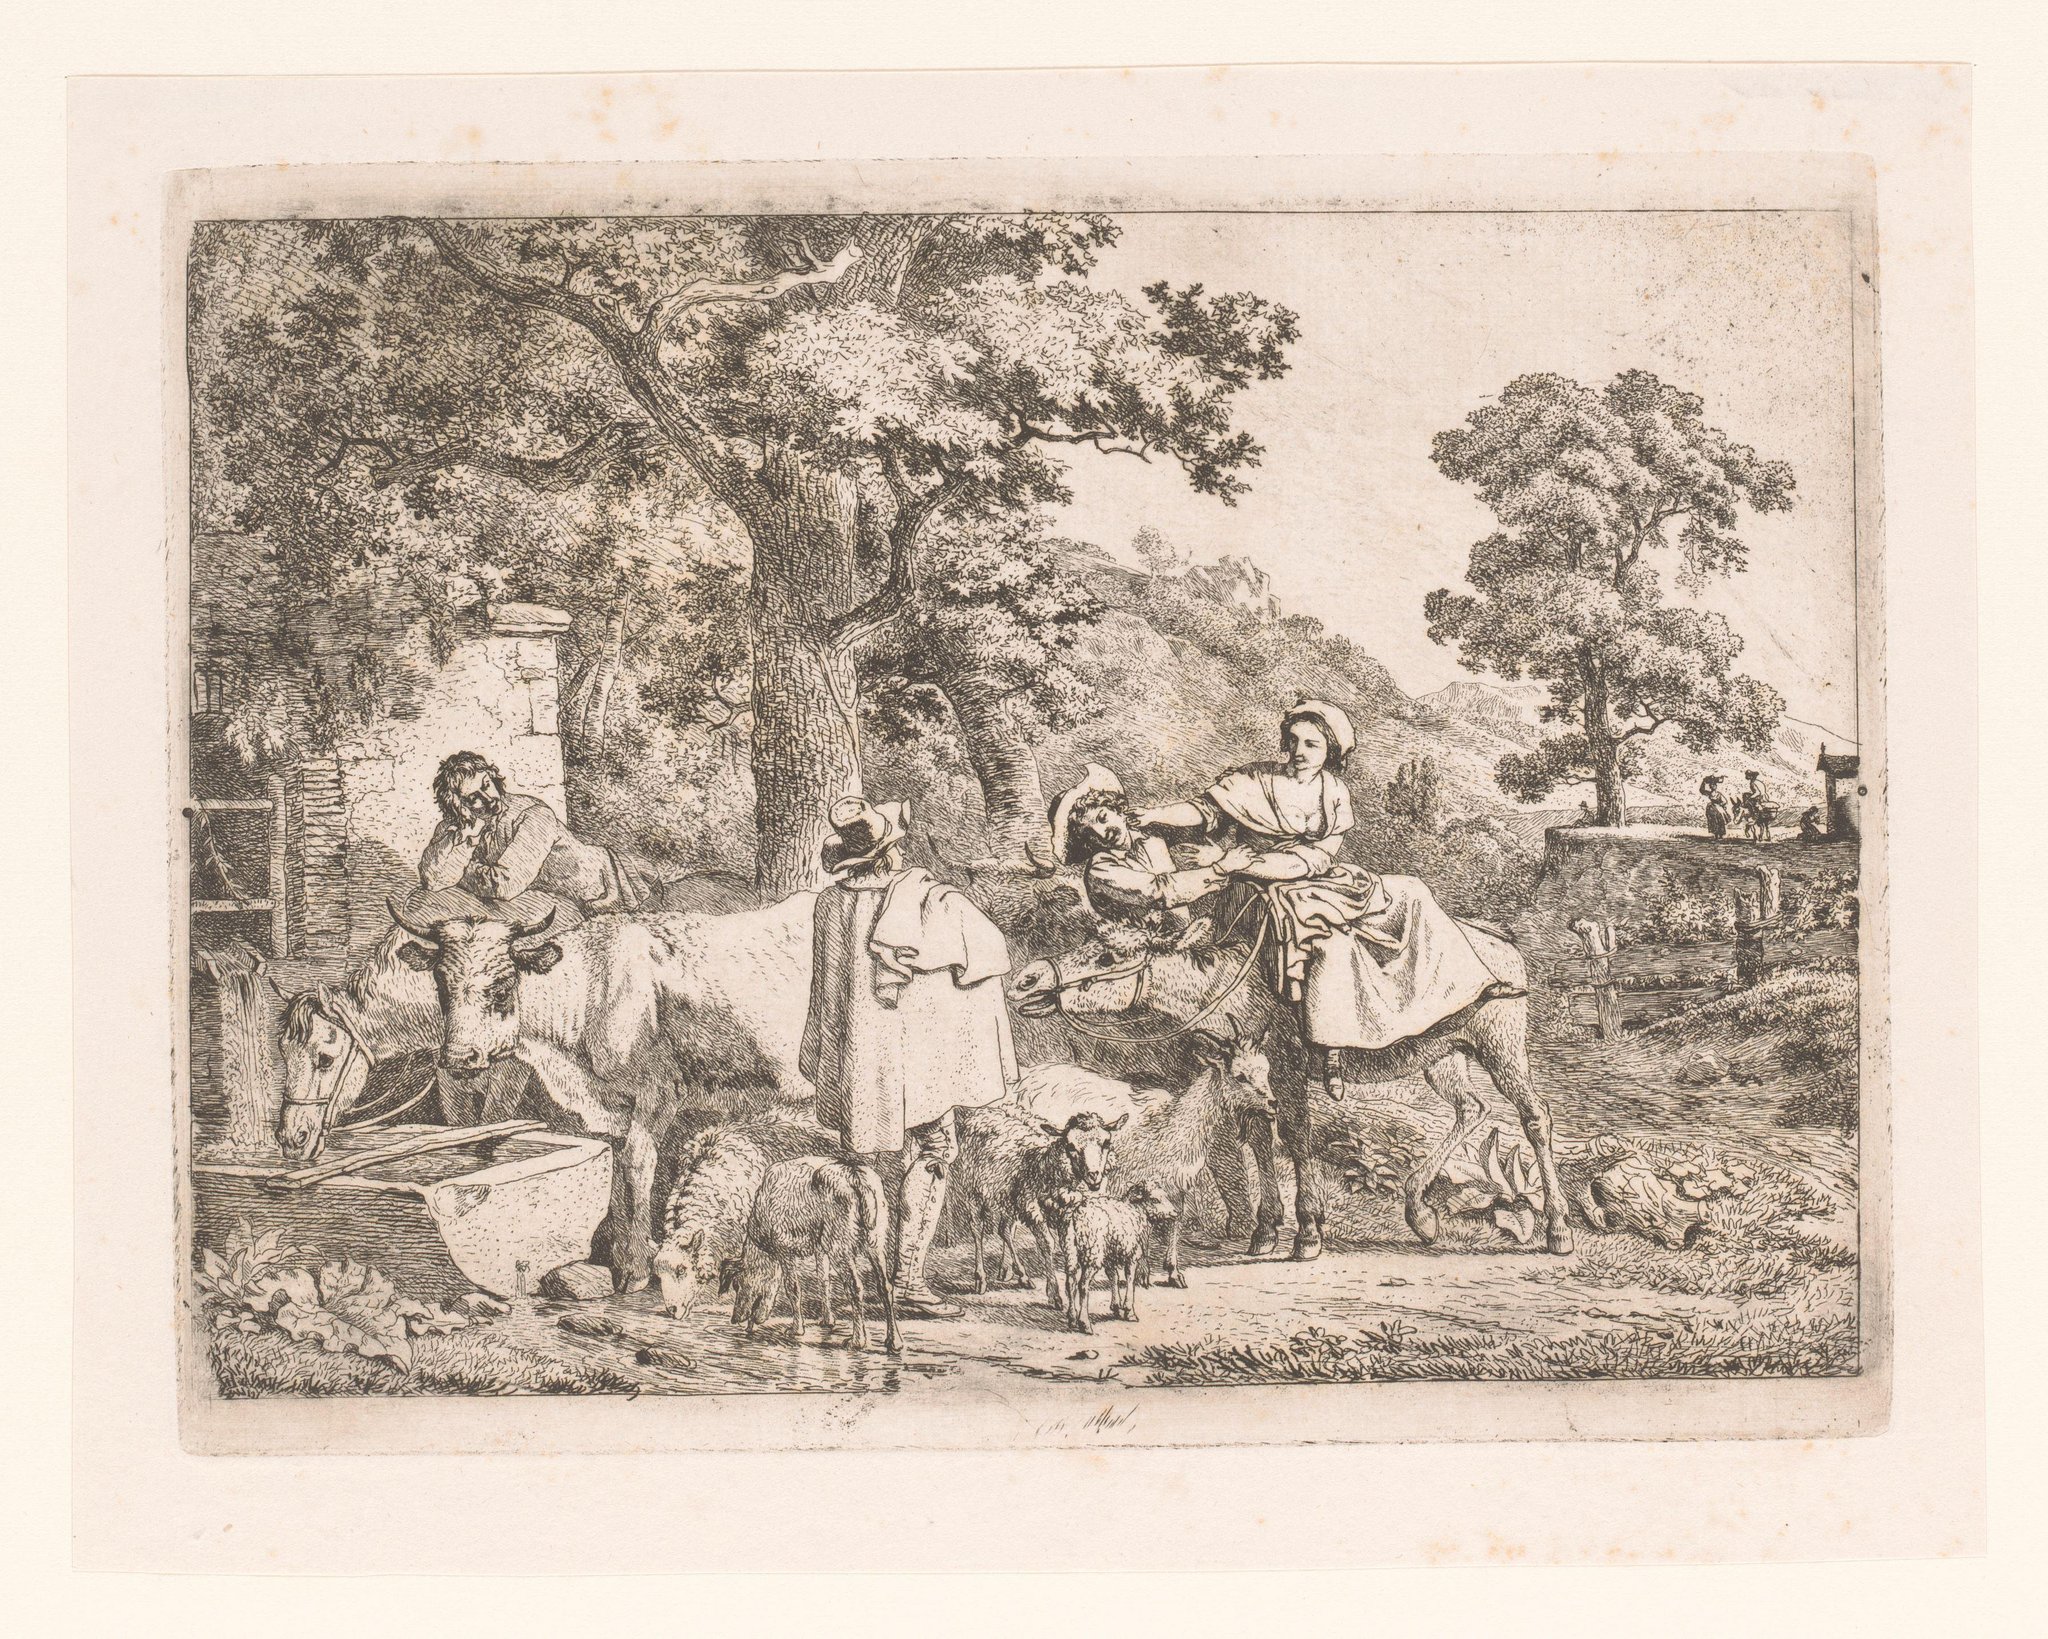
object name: print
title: Drie mannen en een vrouw met vee bij een drinkbak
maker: jean louis demarne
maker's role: draughtsman, painter, print maker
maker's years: 1752-1829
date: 1762-1829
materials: paper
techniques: etching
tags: herding, herdsman, herdswoman, shepherd, shepherdess, cowherd, etc., cattle, pulling the ears (of naughty children), landscapes (+ landscape with figures, staffage)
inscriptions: collector's mark: Lugt 2228